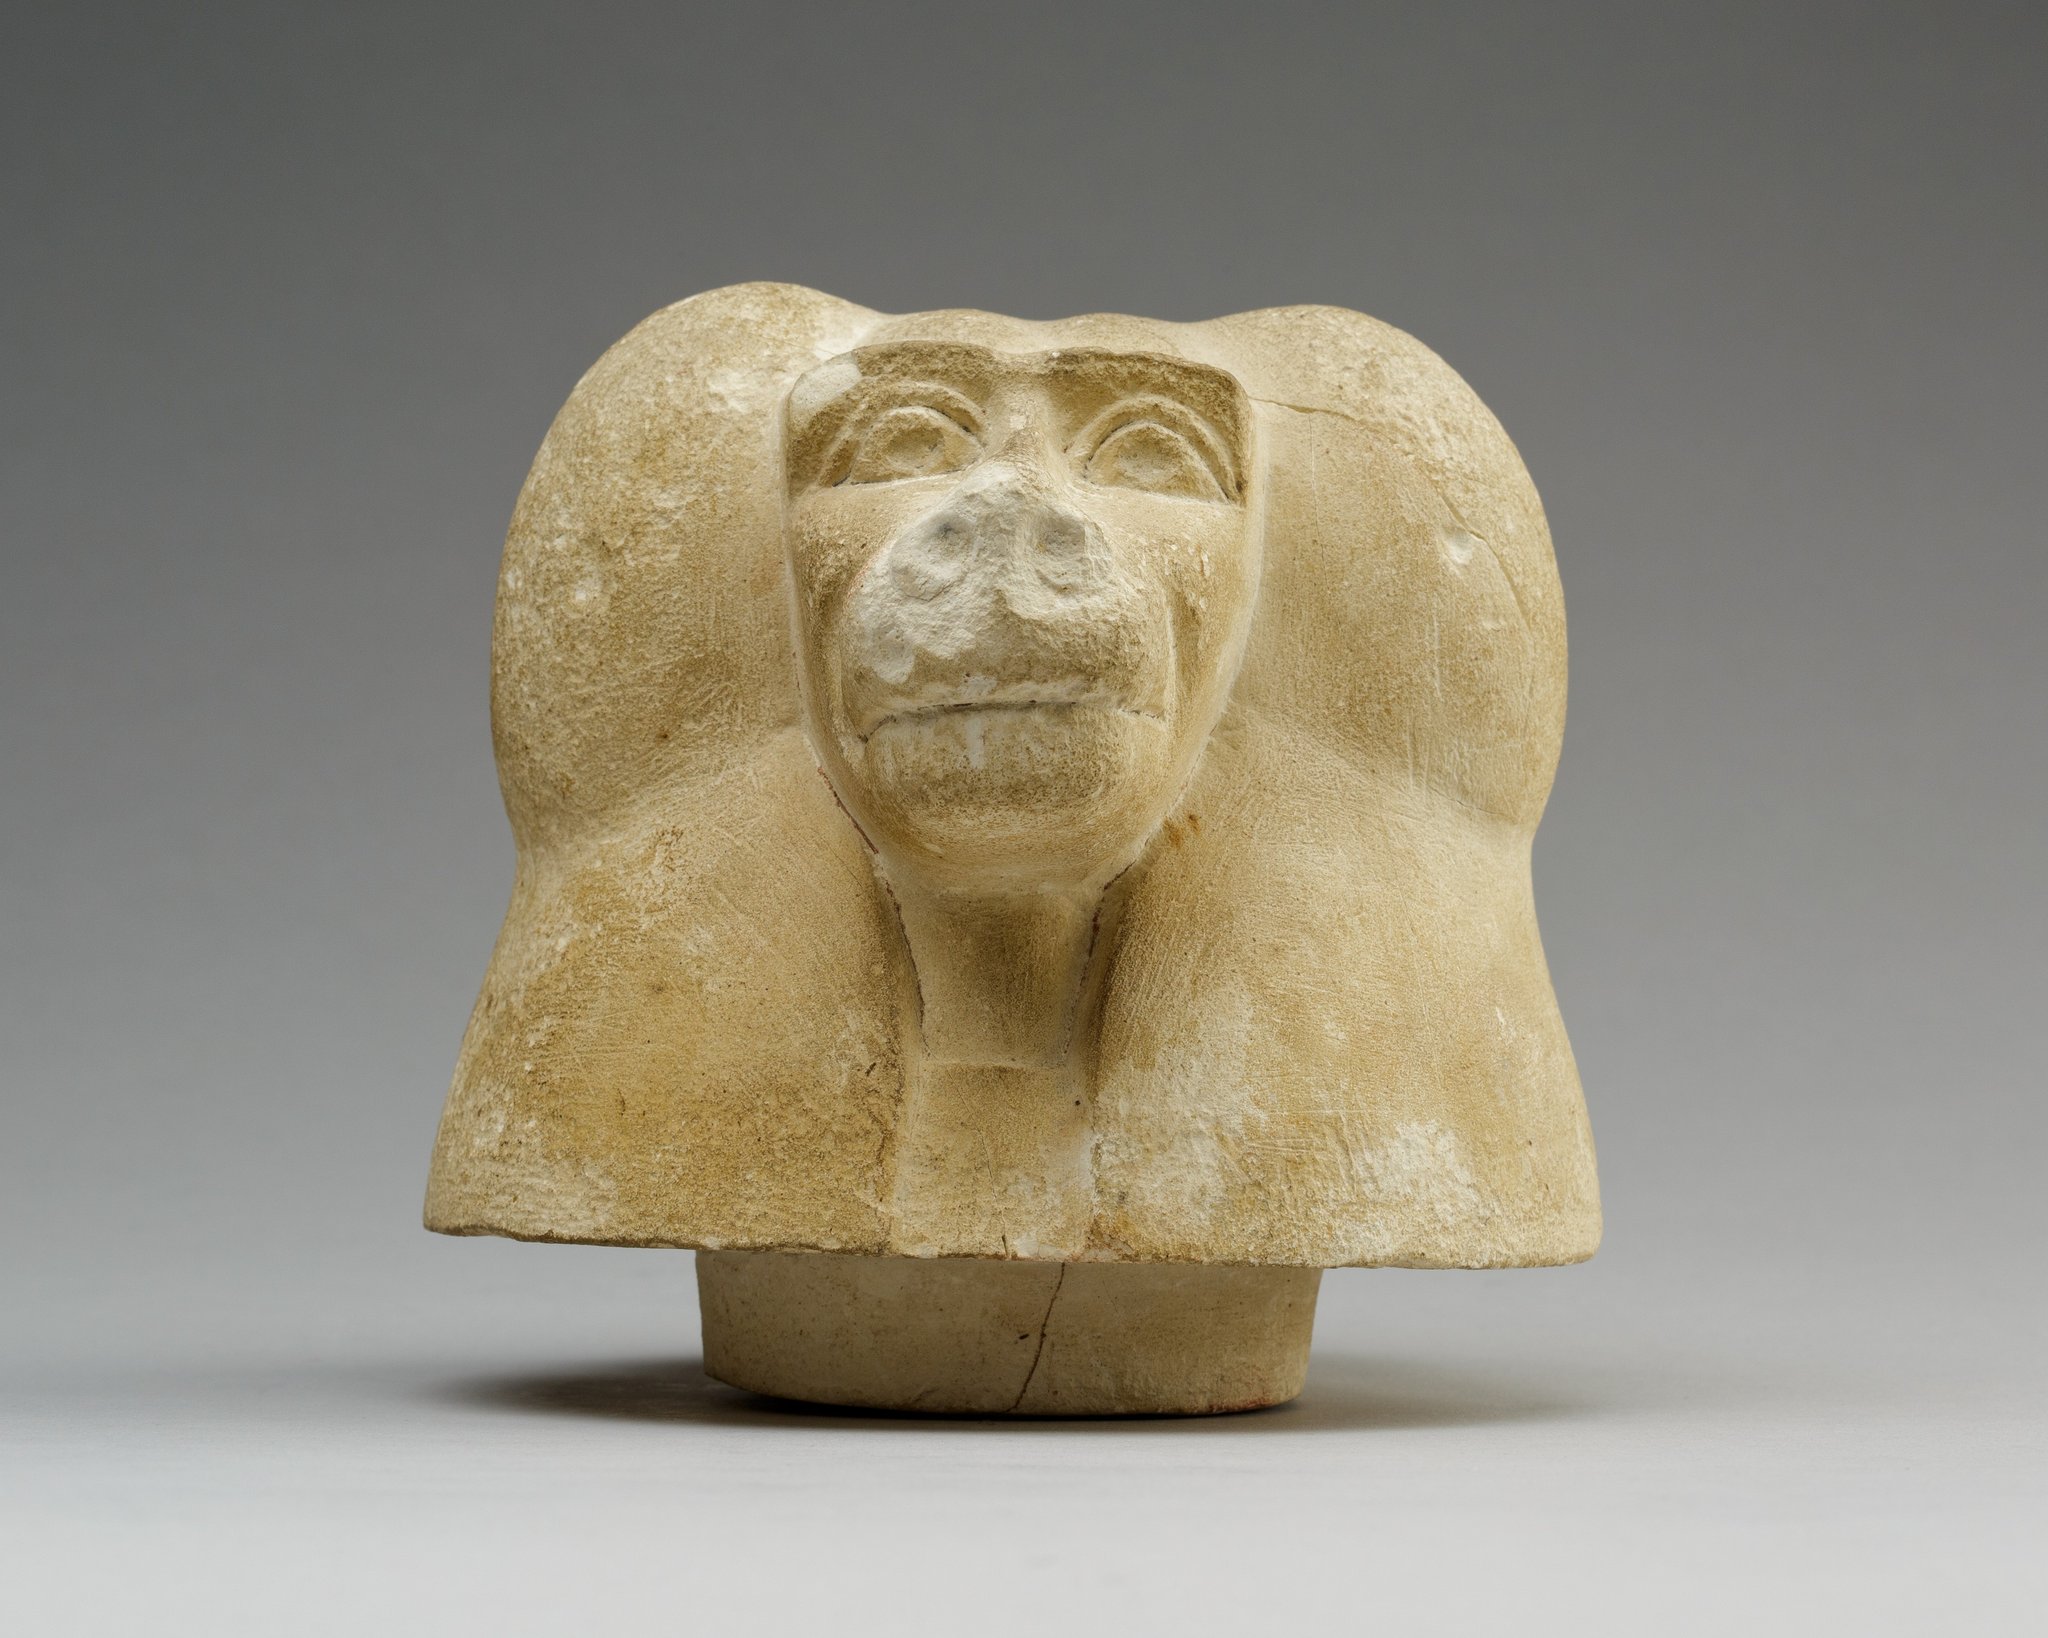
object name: canopic jar lid, hapy, baboon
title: Canopic jar lid with head of a baboon (Hapy)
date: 1070-332 BCE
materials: limestone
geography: egypt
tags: baboons